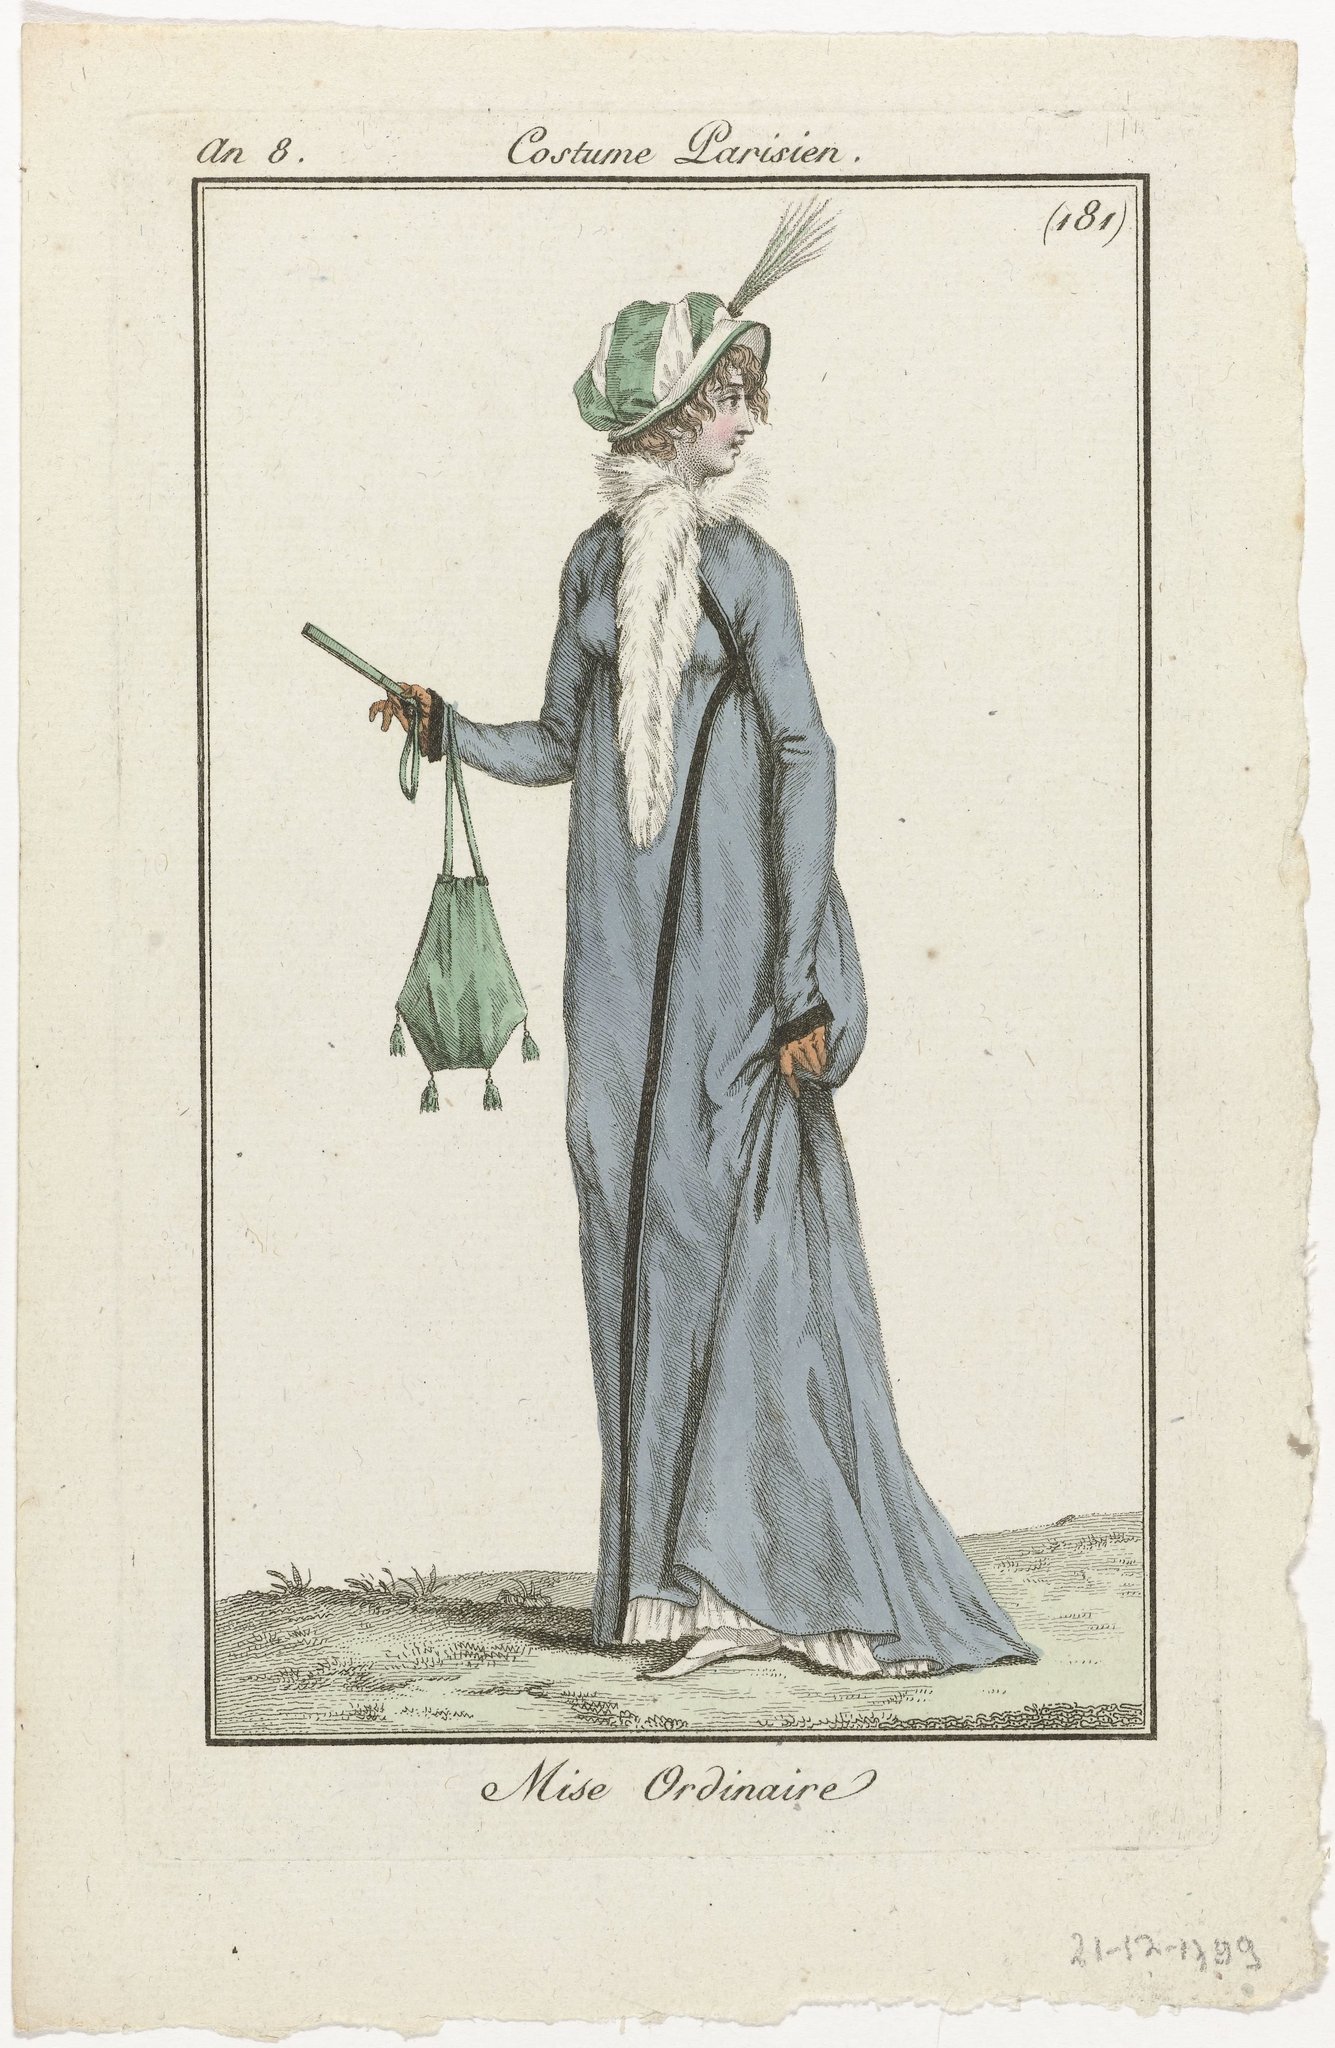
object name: fashion print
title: Journal des Dames et des Modes: Ladies’ Fashion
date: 1799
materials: paper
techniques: engraving, hand coloring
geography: paris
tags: bag (reticule) (+ women's clothes), coat (+ women's clothes), neck-gear ~ clothing (palatine) (+ women's clothes), head-gear (+ women's clothes), fashion plates, shoes, sandals (+ women's clothes), fan (+ women's clothes)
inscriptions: caption: ‘Mise Ordinaire’, title: ‘Costume Parisien.’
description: After the turbulent years of the French Revolution, in 1797 a fashion magazine was finally published again: the Journal des Dames et des Modes. Under the direction of Pierre de La Mésangère, it developed a cosmopolitan flair. The very best draughtsmen were recruited to produce the fashion illustrations, called Costumes Parisiens. They visited spots all over Paris to ensure they saw the latest styles. These included high-waisted gowns with low necklines, ‘Greek’ slippers with cross-laces 1, genuine Kashmiri shawls 2, reticules 3 (small stylish handbags), poke bonnets 4 and full-length English coats knowns as redingotes 5.